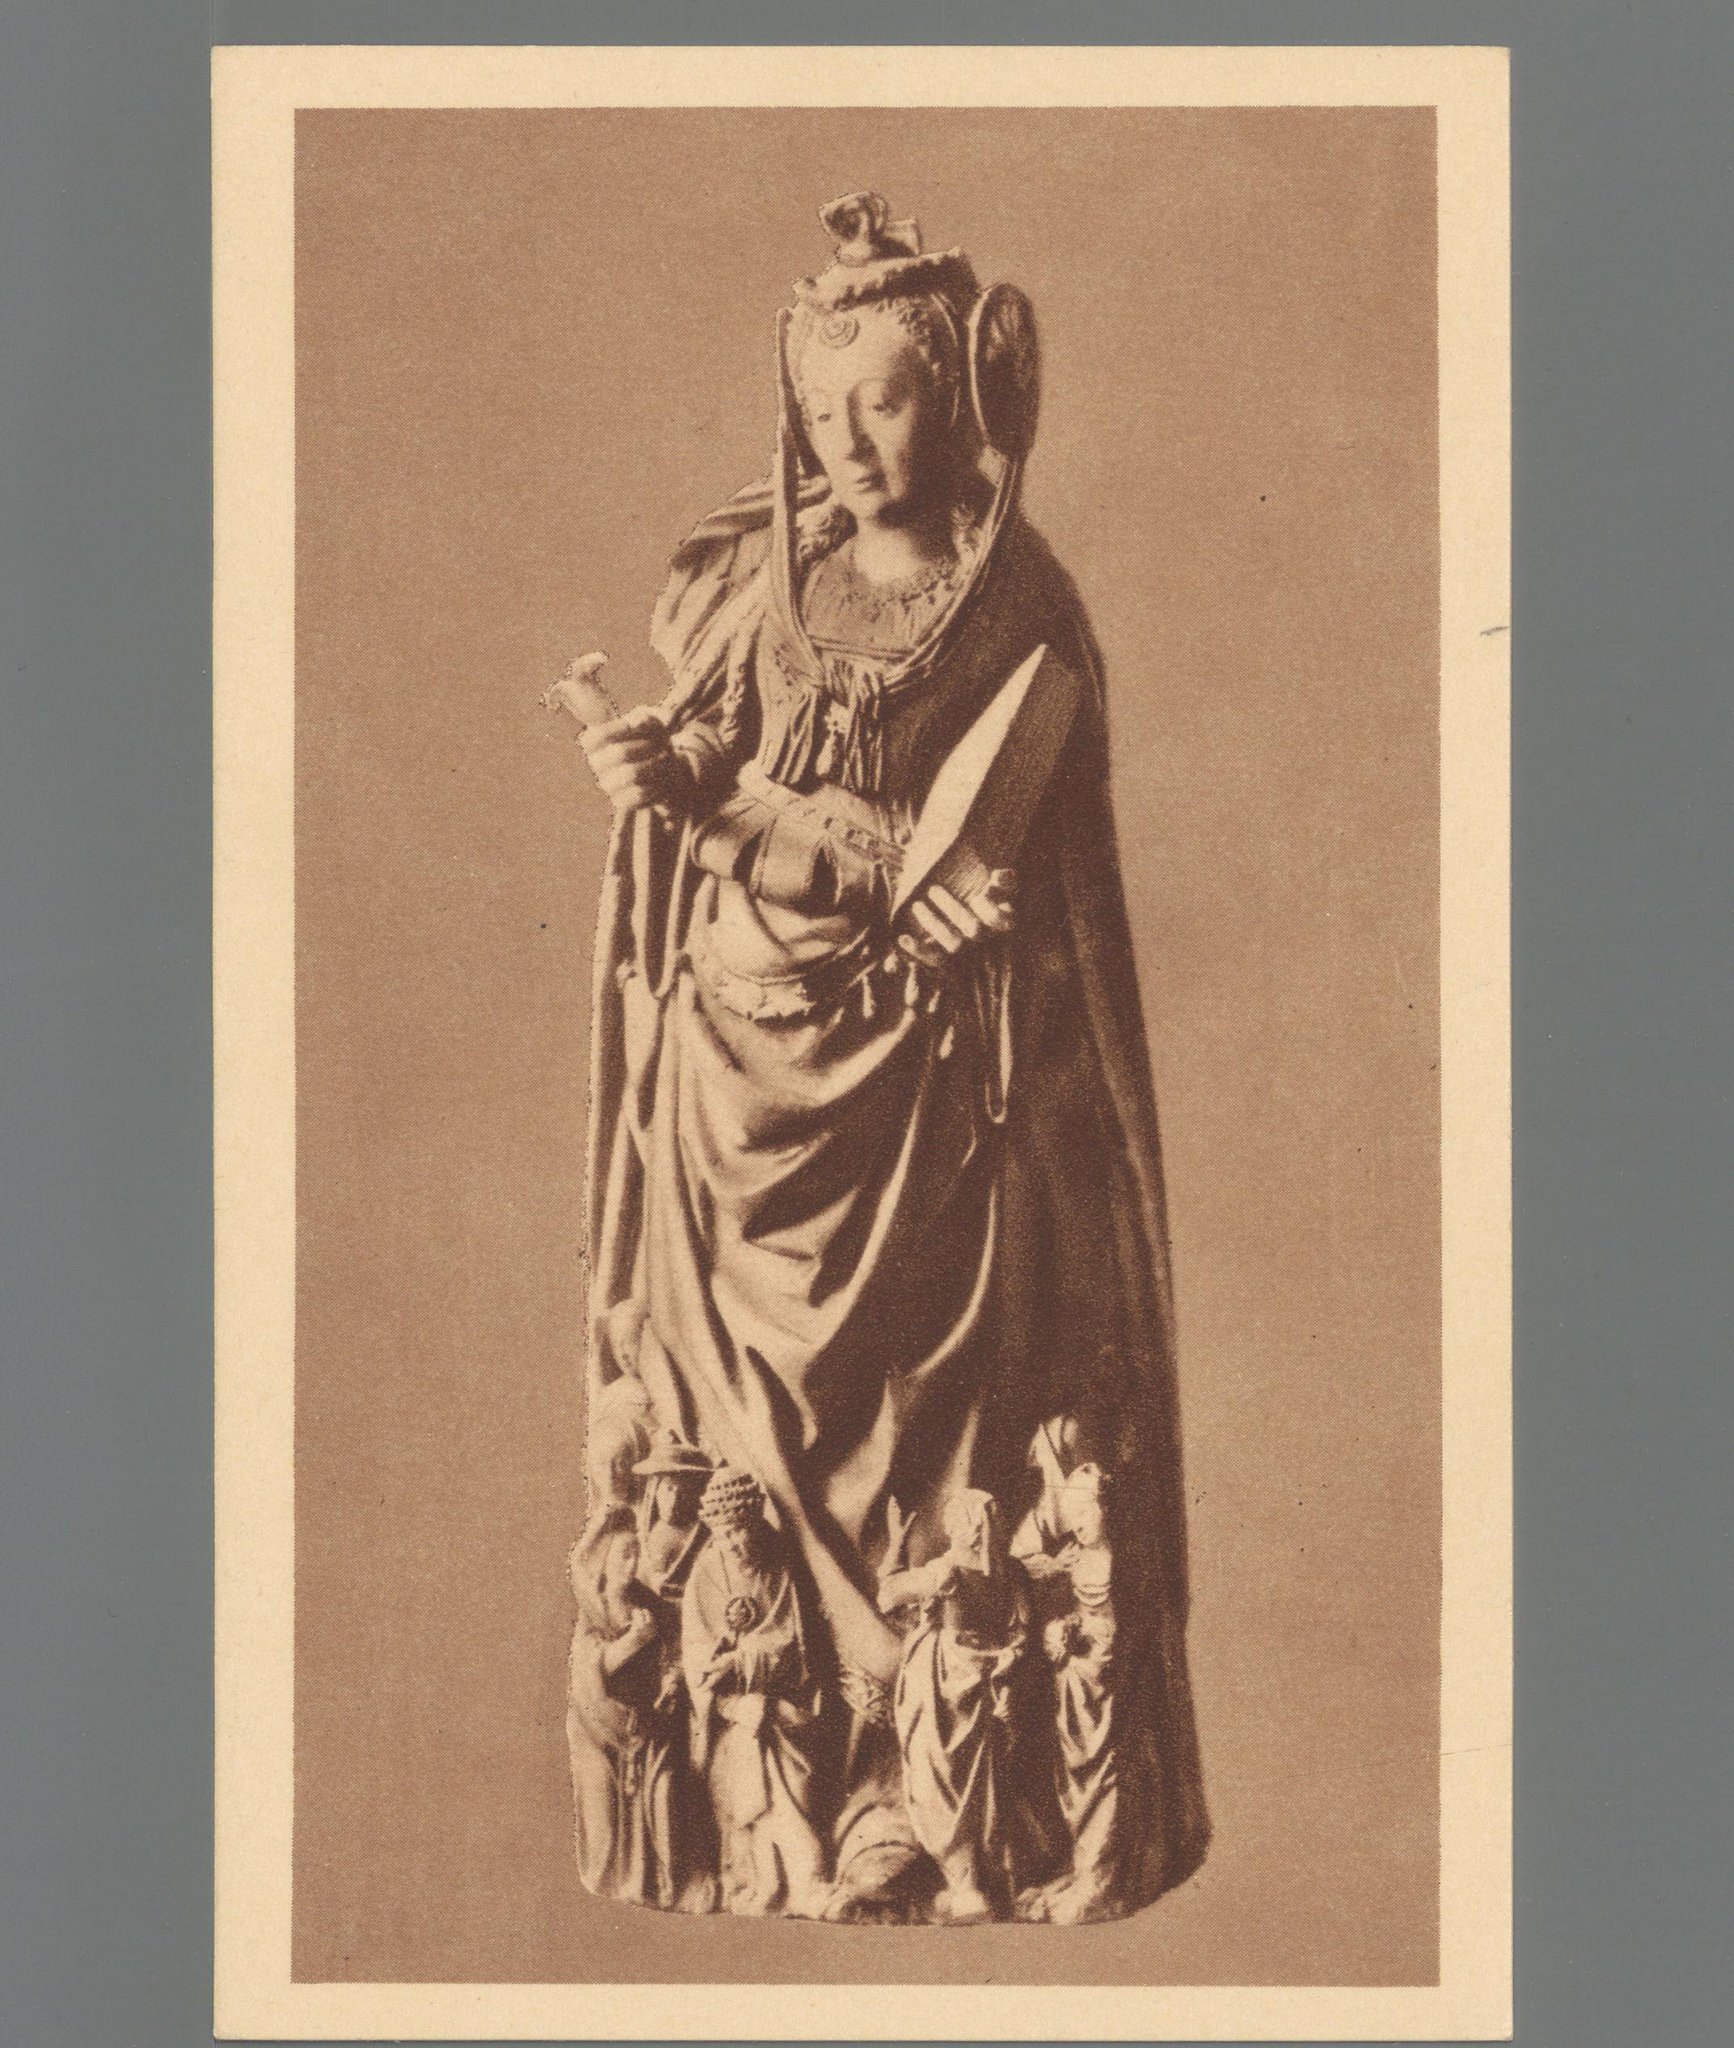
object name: ansichtkaart, prentbriefkaart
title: Nederrijnsche School, omstreeks 1530. St. Ursula, eikenhout, gepolichromeerd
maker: Anonymous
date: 1921-1940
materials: cardboard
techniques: rotogravure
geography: leiden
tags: the virgin martyr ursula of cologne; possible attributes: arrow, banner with red cross, cloak of ermine, crown, ship, sculpture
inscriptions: collector's mark: ‘AFE v S’